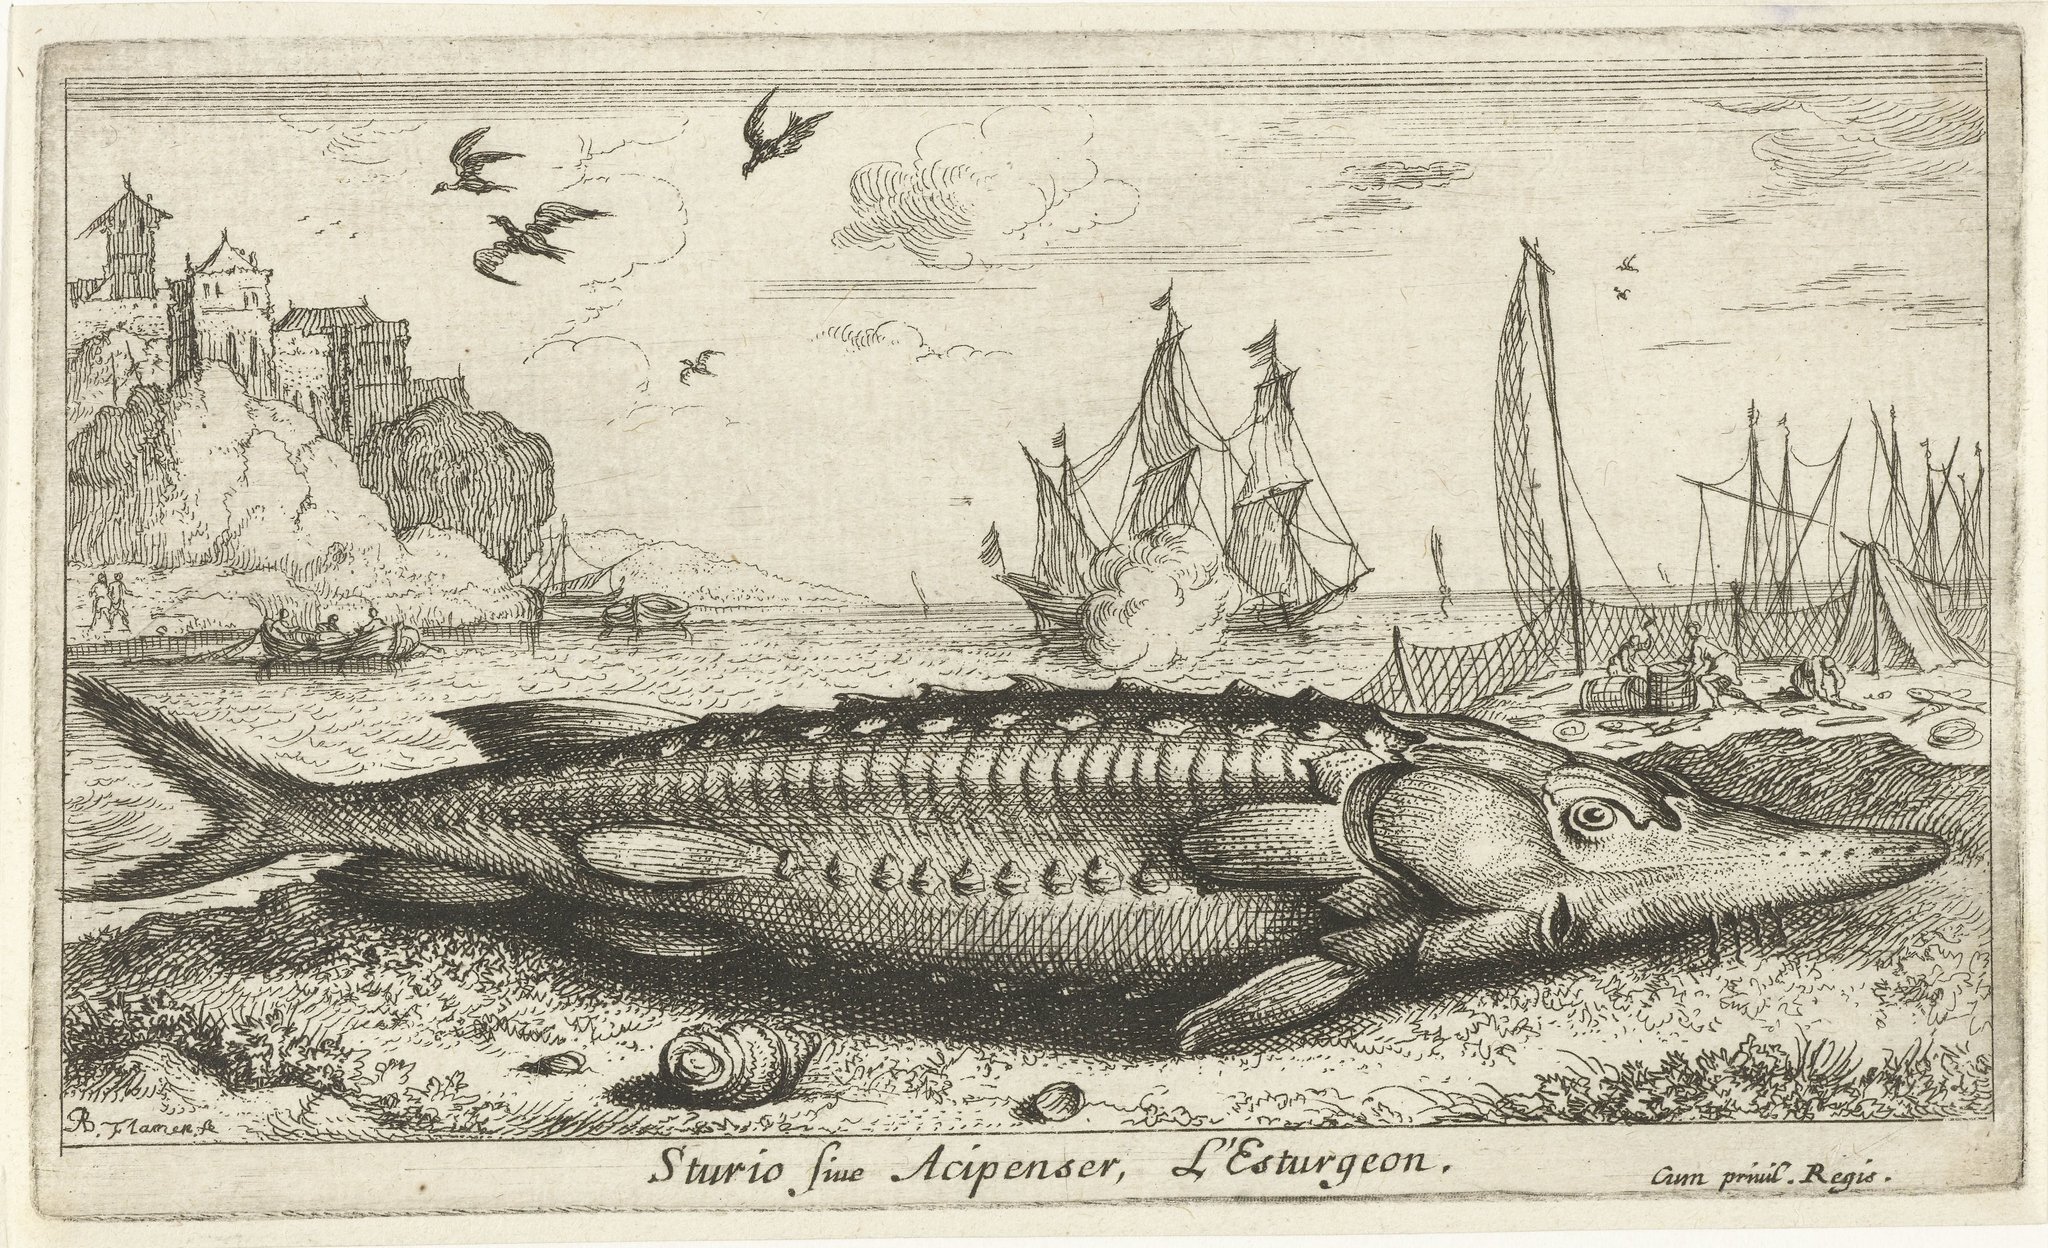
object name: print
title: Sturio siue Acipenser, L'Esturgeon.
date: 1664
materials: paper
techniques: etching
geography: paris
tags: bony fishes: sturgeon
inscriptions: collector's mark: Lugt 2228